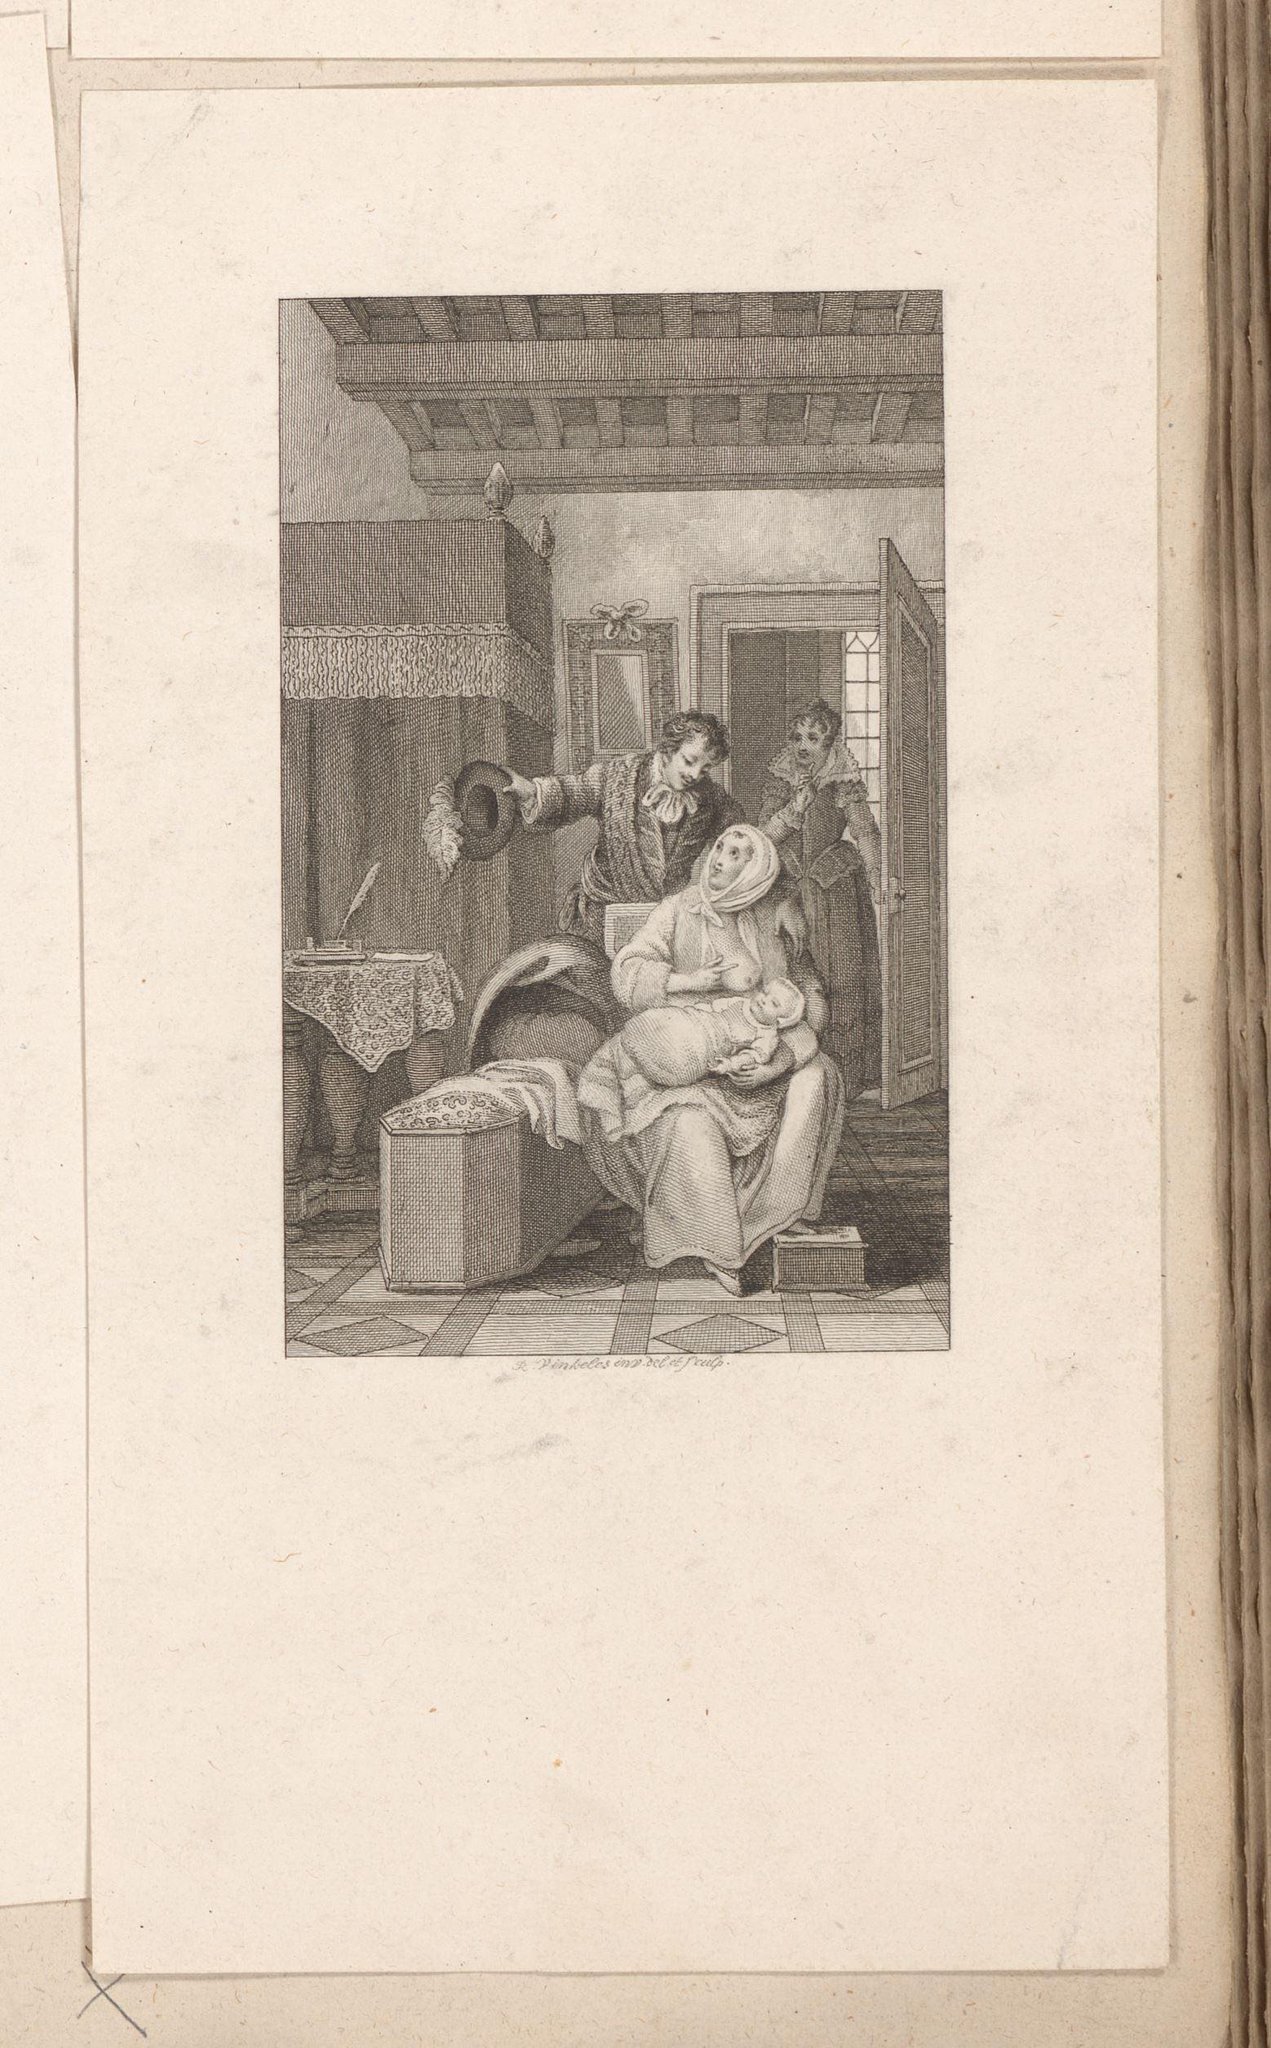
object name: print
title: Hellemans op bezoek bij Hillegonda en haar kind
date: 1814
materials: paper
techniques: engraving, etching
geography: amsterdam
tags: breasts giving milk, baring the head, lifting one's hat, feeding a baby, mother and baby or young child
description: Proefdruk van een boekillustratie in: Loosjes, Adriaan Pietersz. Het leven van Hillegonda Buisman: een Hollandsche familiegeschiedenis uit de zeventiende eeuw. Deel 3. Haarlem: Adriaan Loosjes, 1814.